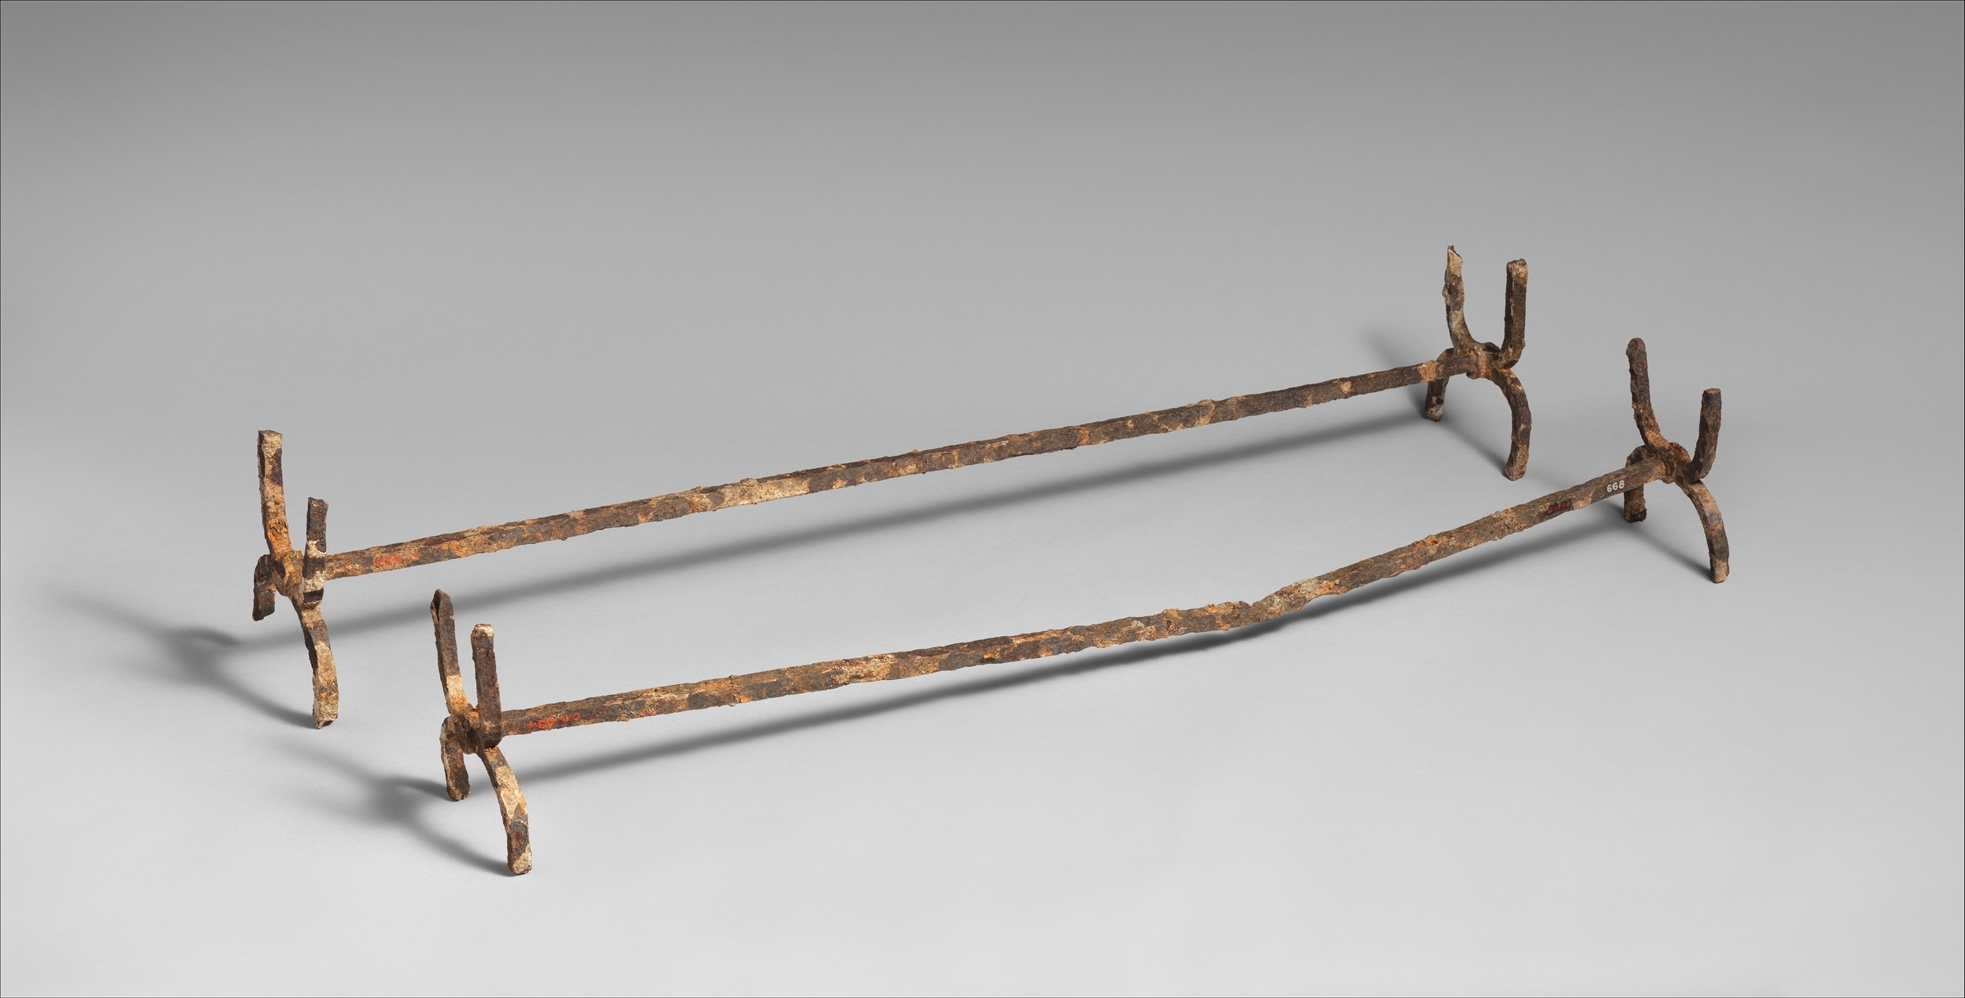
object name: fire dog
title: Iron fire-dog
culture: etruscan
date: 550 BCE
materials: iron